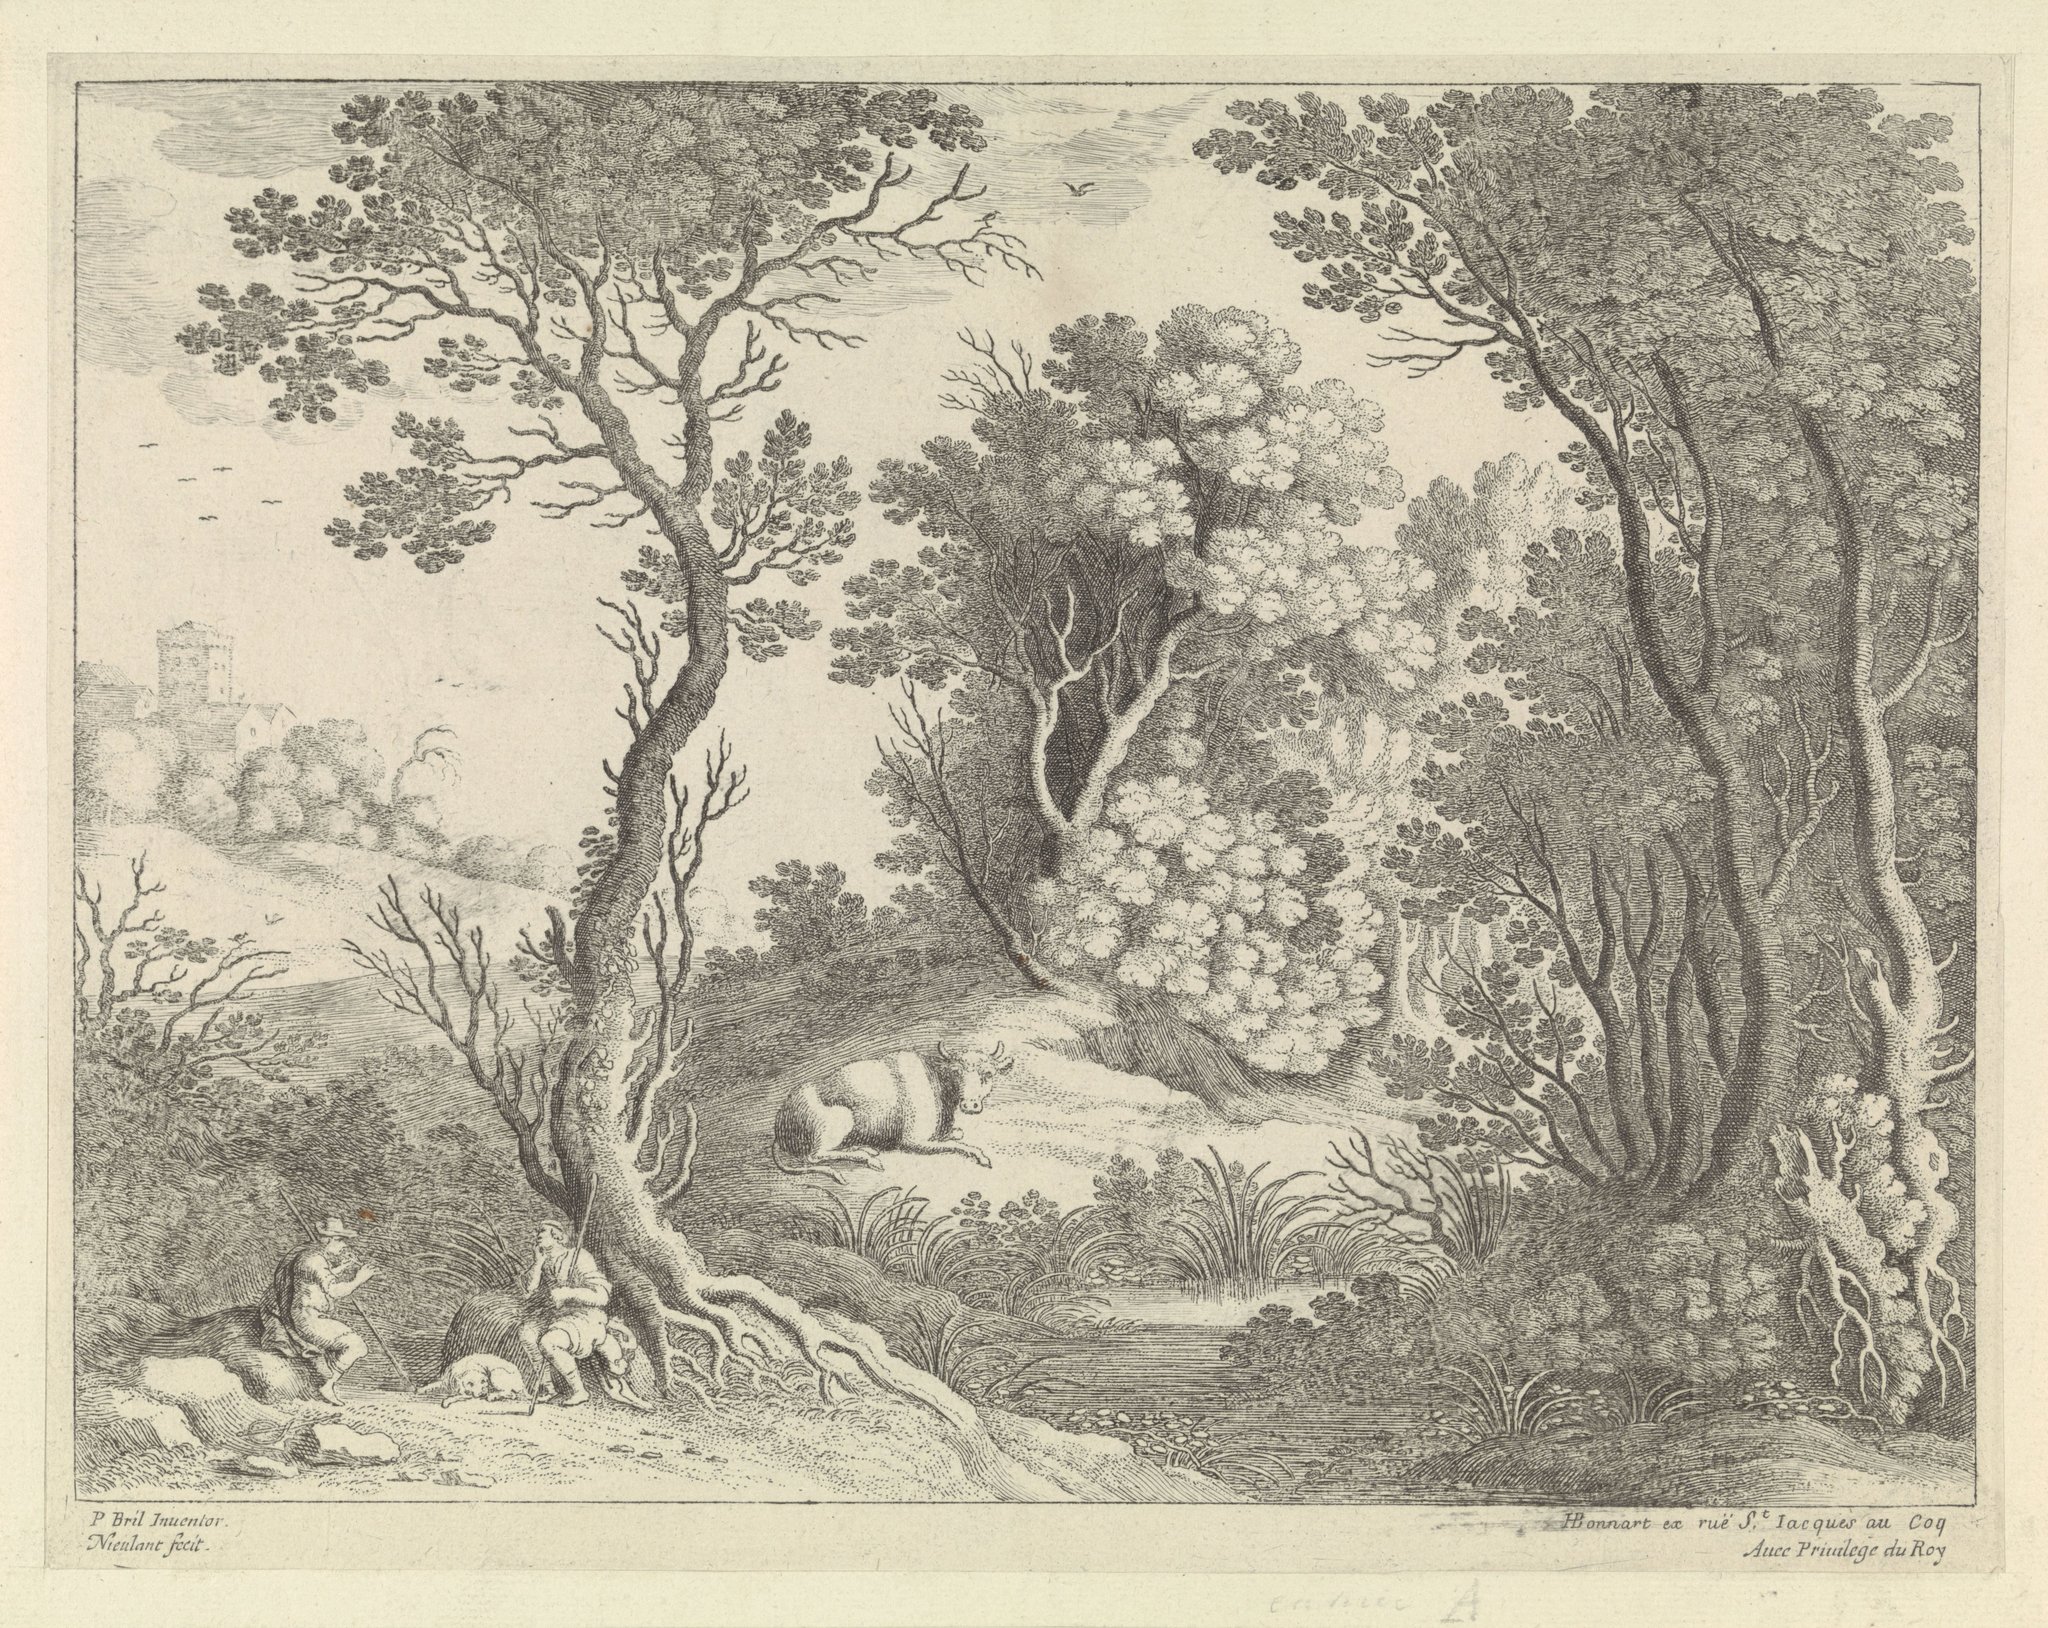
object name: print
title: Mercurius, Argus en Io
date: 1594-1635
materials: paper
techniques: engraving, etching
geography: paris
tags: trees, mercury lulls argus into sleep by making music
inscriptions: collector's mark: Lugt 2228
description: Mercurius speelt op zijn fluit, zodat Argus, die Io moet bewaken, in slaap valt. De in een koe veranderde Io ligt tussen de bomen.